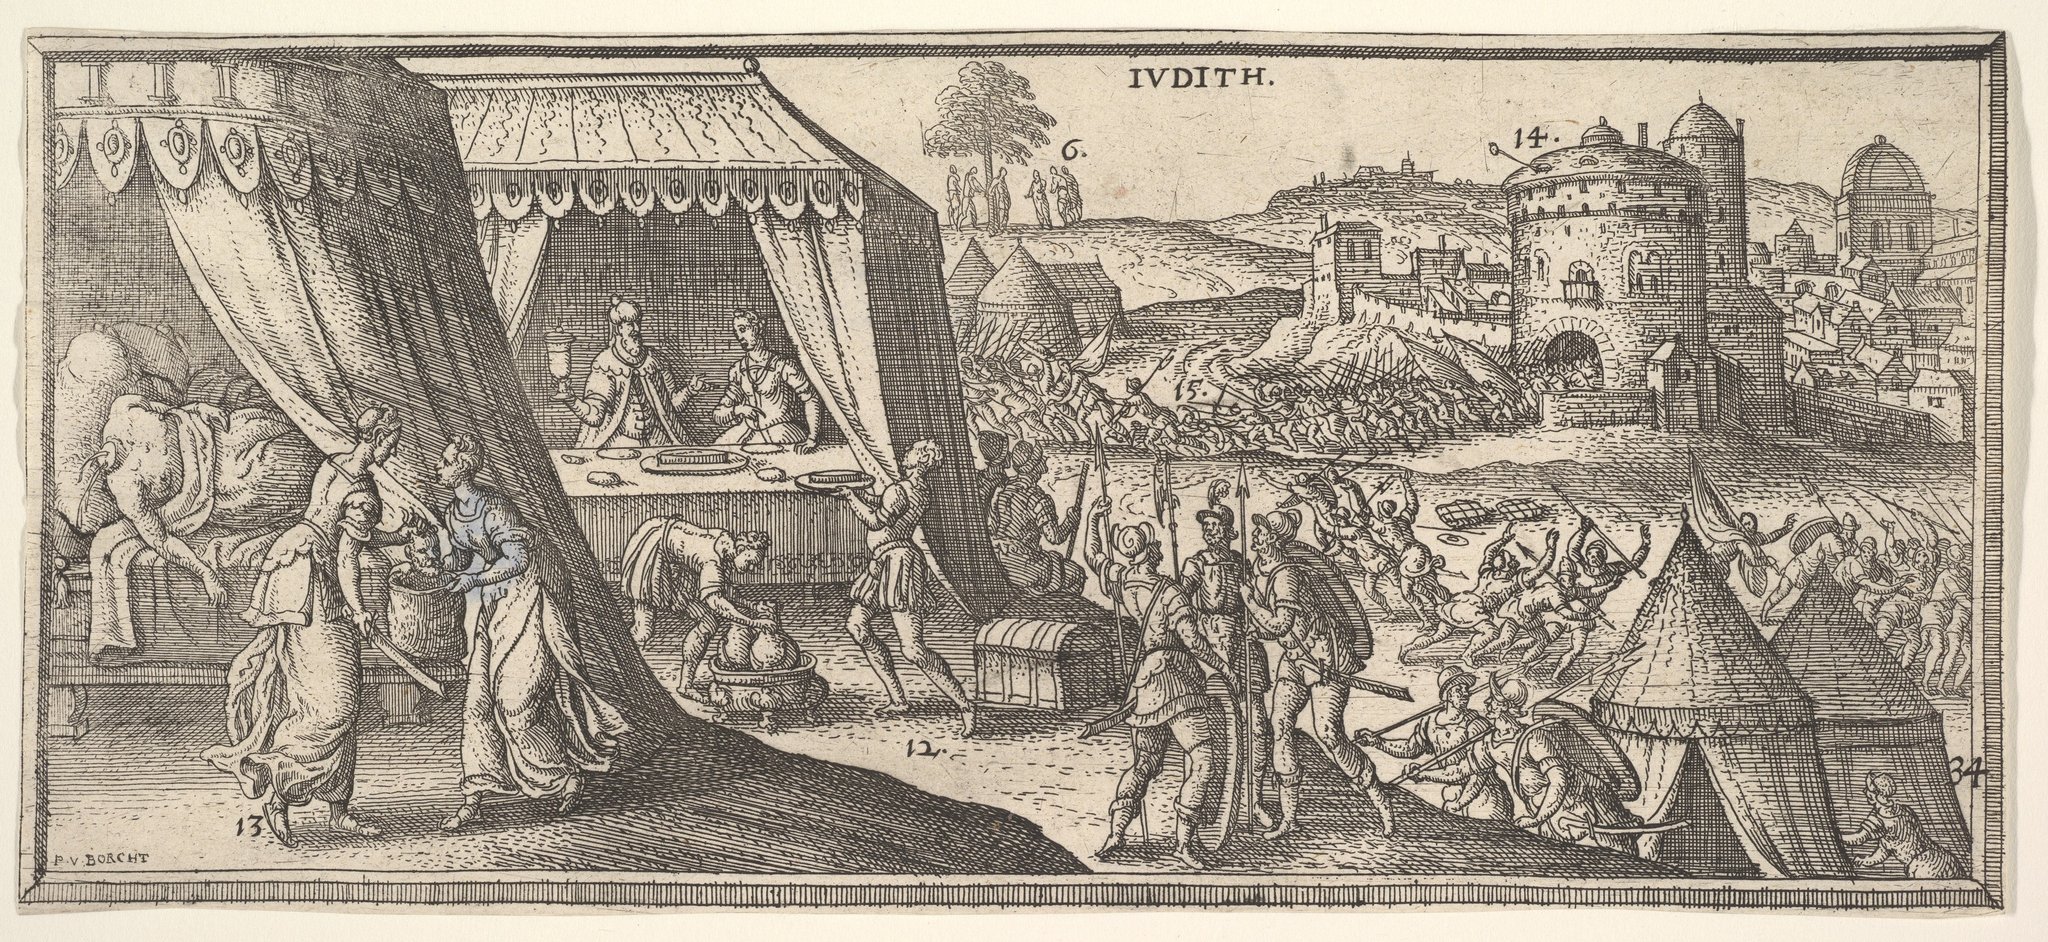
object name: print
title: Judith, illustration to "Biblesche figuren ofte afbeeldingen..." by Hendrik Jansen van Barrefelt, called Hiel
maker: peeter van der borcht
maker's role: artist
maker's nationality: netherlandish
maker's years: 1530-1608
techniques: etching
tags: buildings,men,women,judith